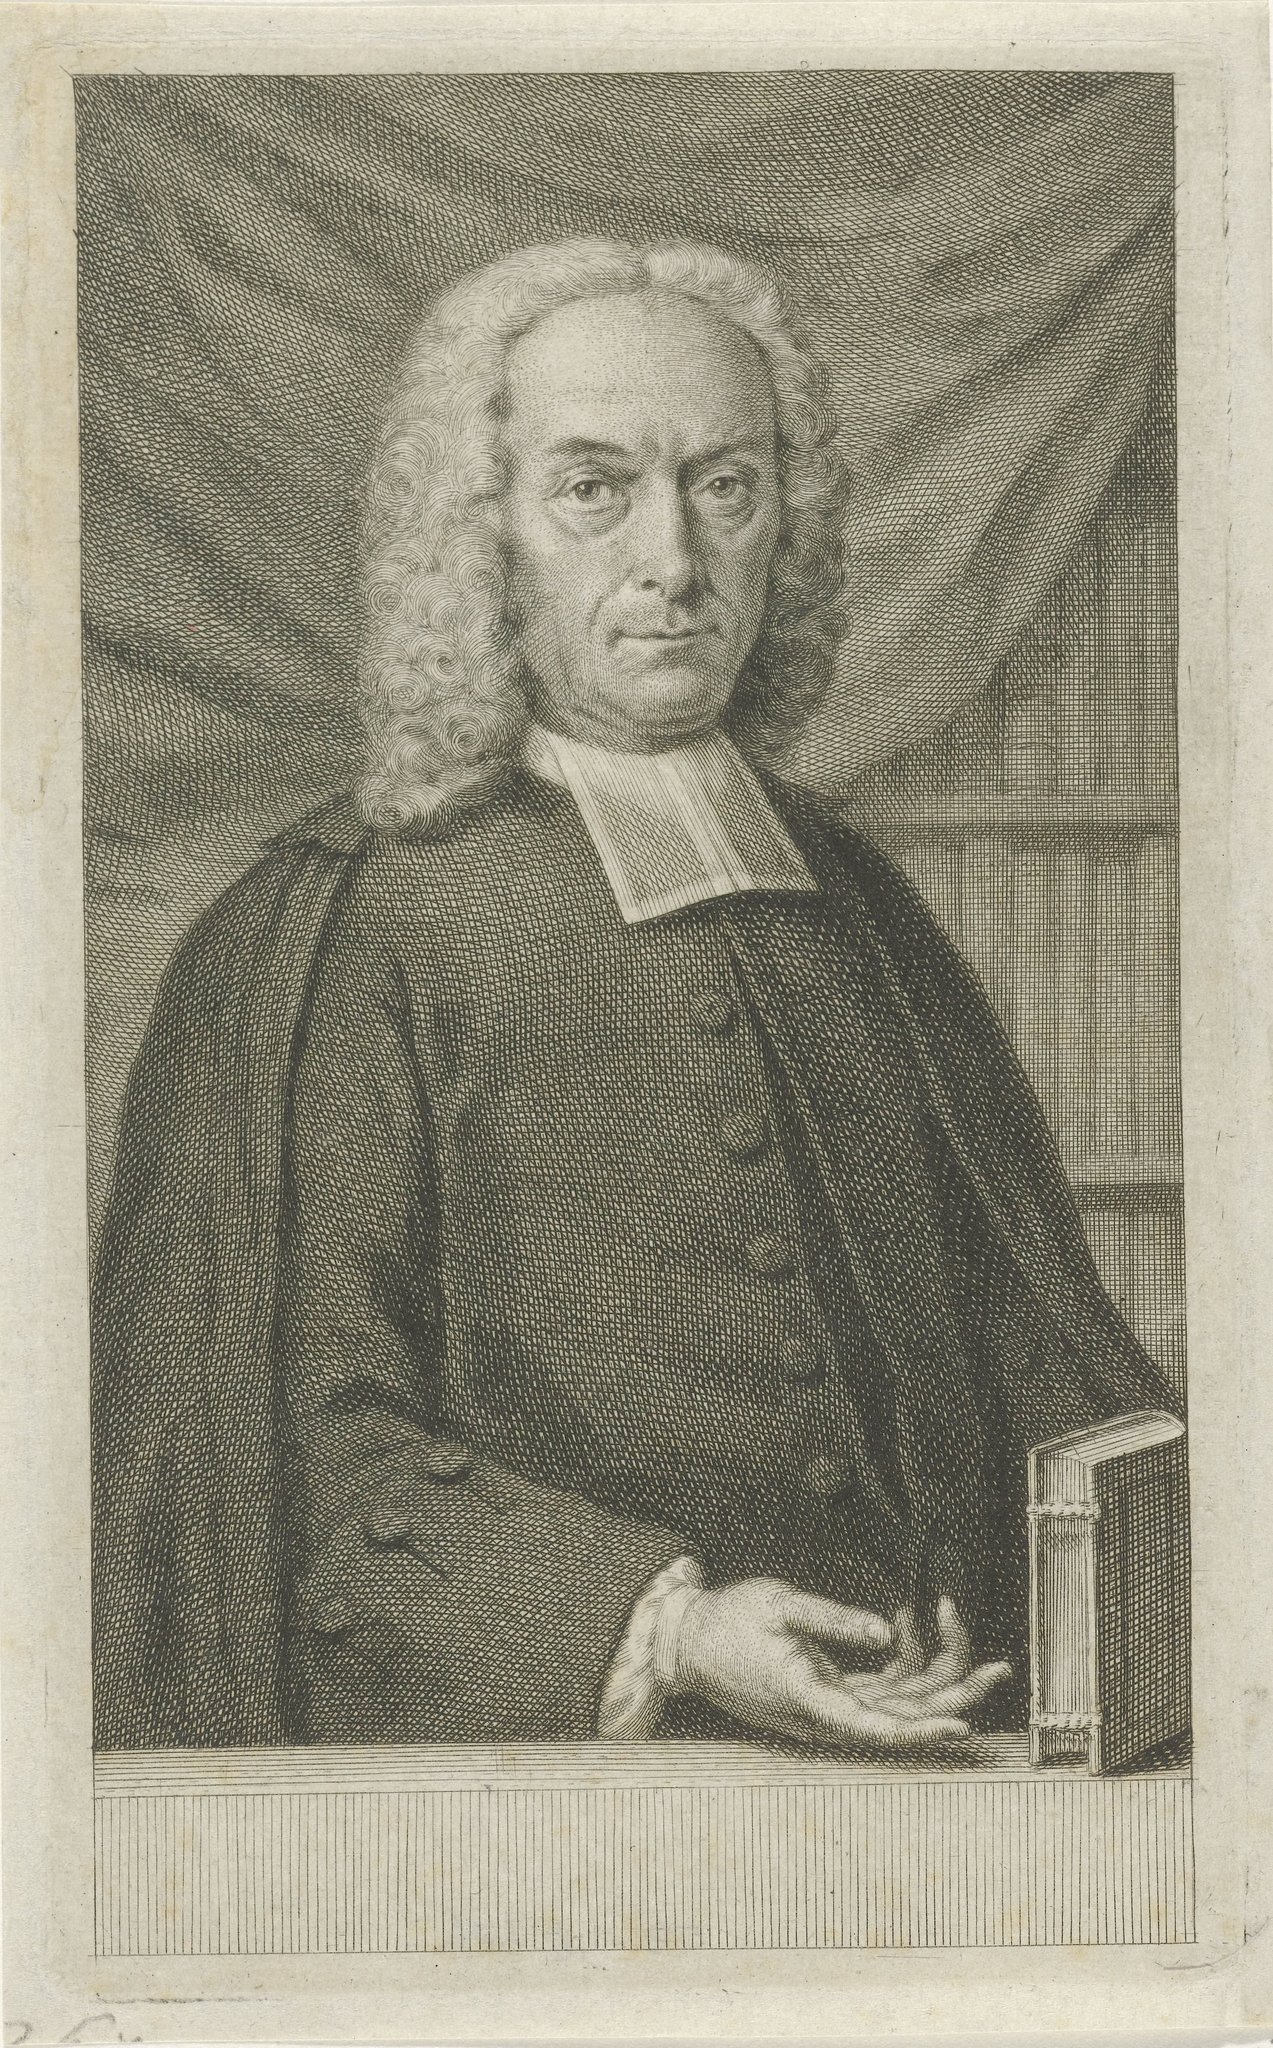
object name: print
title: Portret van Joannes Deknatel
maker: jacob houbraken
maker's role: draughtsman, print maker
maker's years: 1698-1780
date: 1760-1762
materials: paper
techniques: engraving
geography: amsterdam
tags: norden, predikant, joannes deknatel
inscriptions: collector's mark: Lugt 2228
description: Portret ten halven lijve van Joannes Deknatel voor een gordijn en een boekenkast. Voor hem een plint waarop een bijbel.